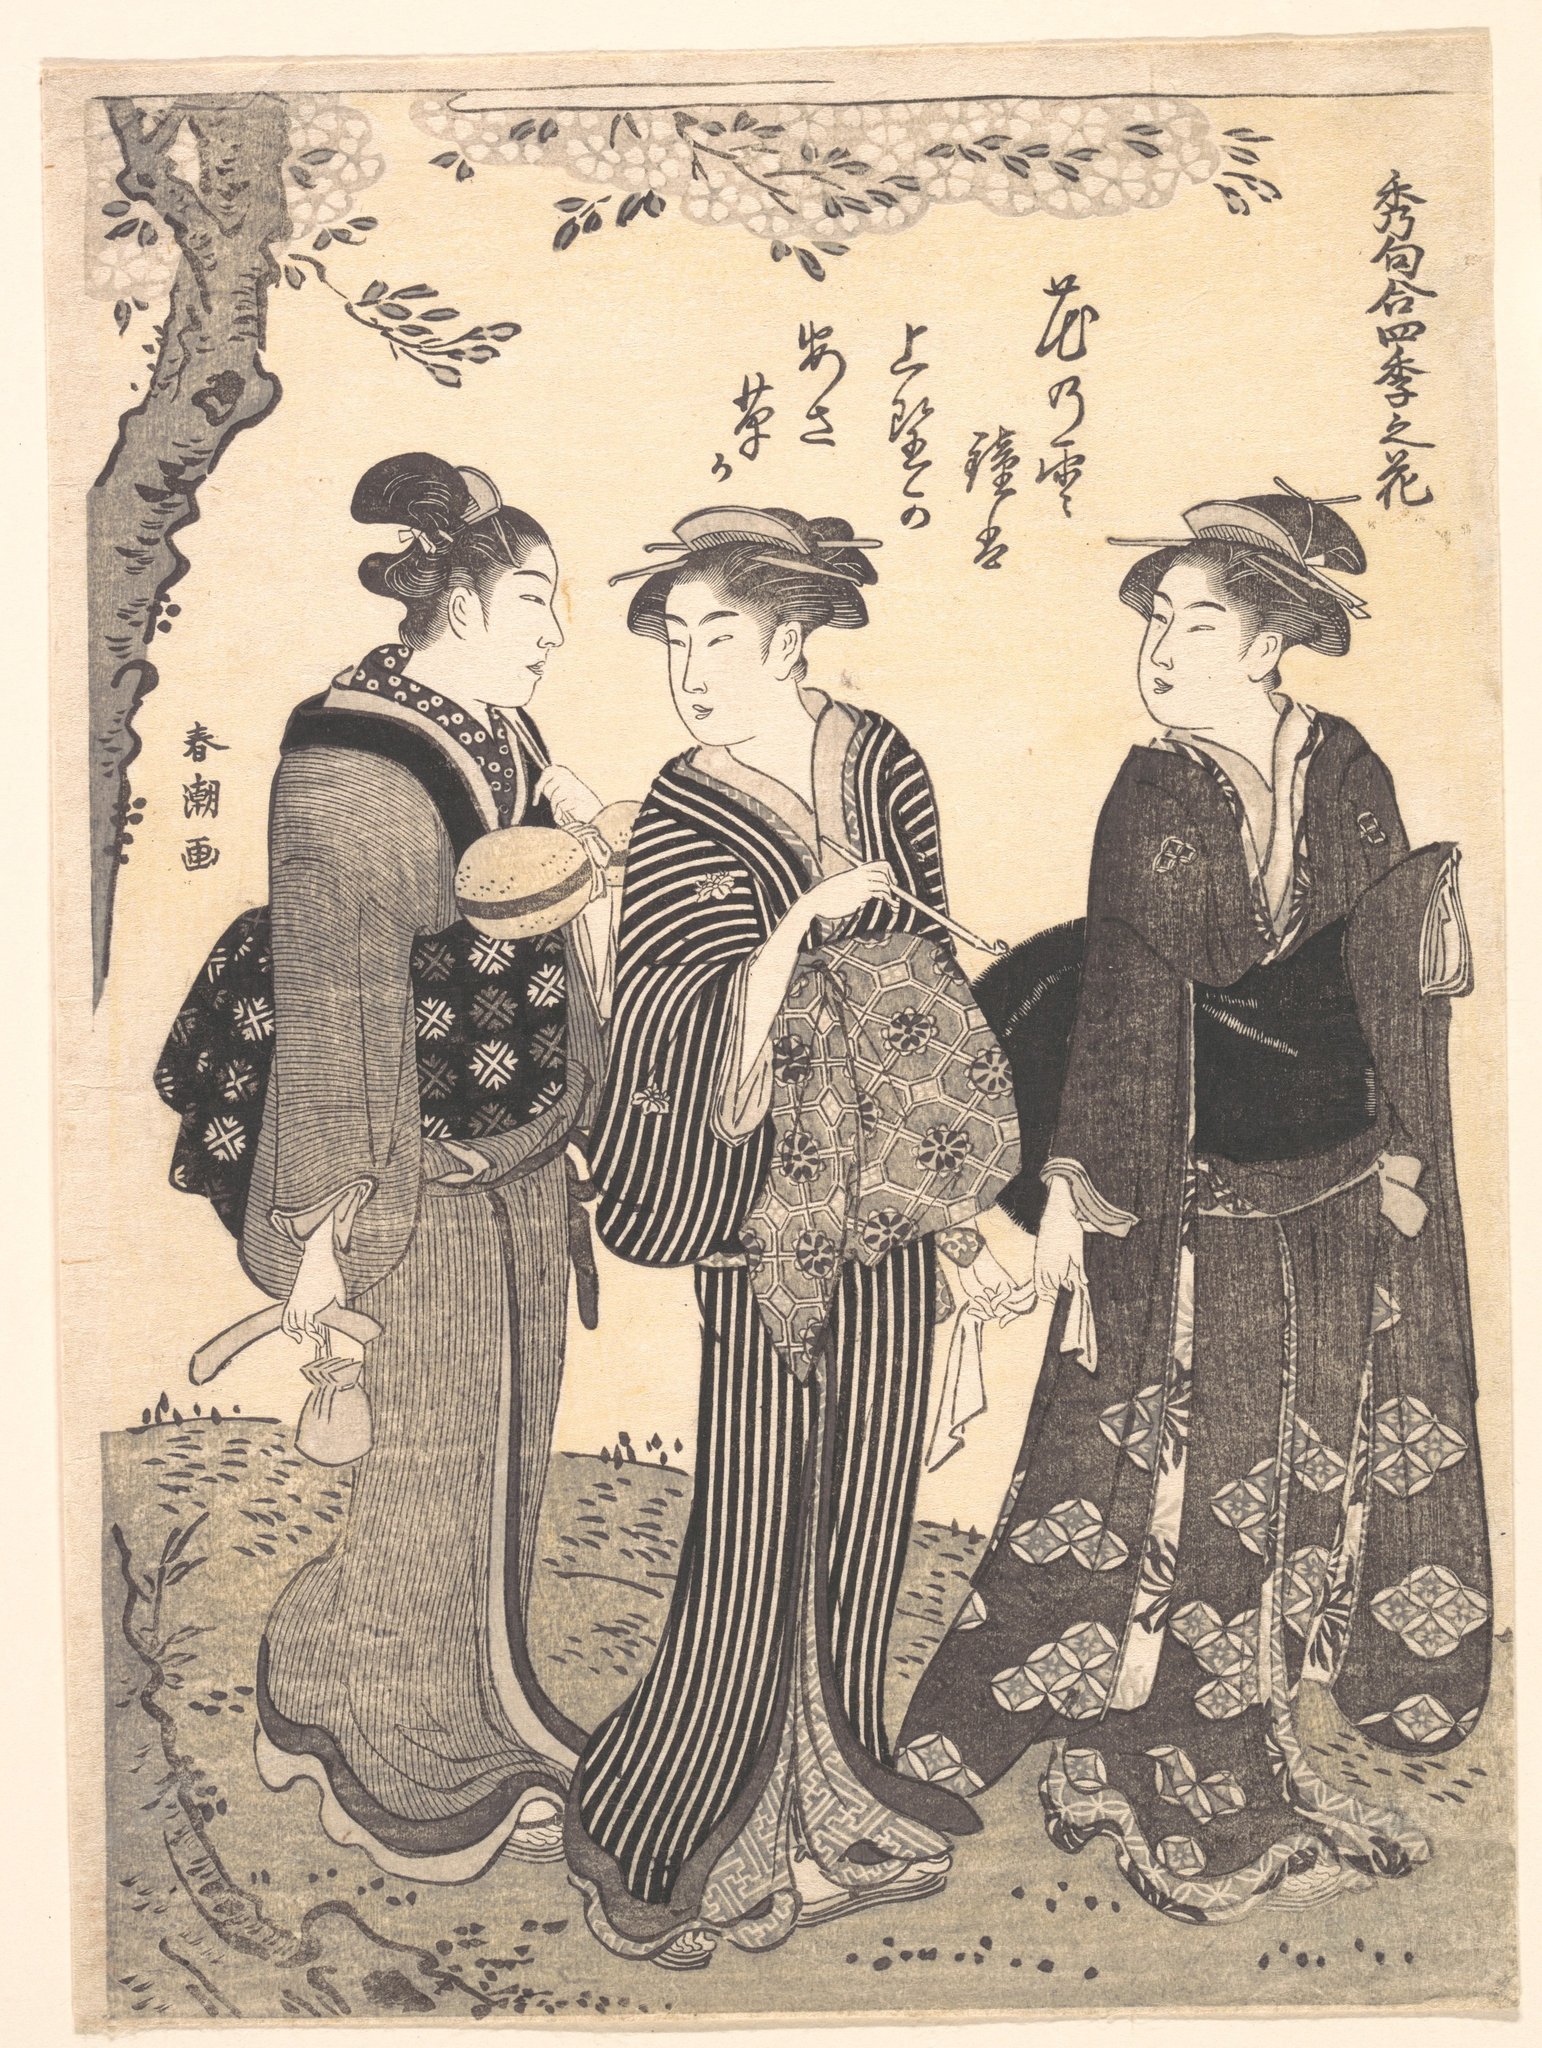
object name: print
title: Two Women Accompanied by a Maid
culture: japanese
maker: katsukawa shunchō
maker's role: artist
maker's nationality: japanese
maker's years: 1775-1795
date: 1780-1795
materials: ink, paper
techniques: woodblock print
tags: bedrooms,women,servants